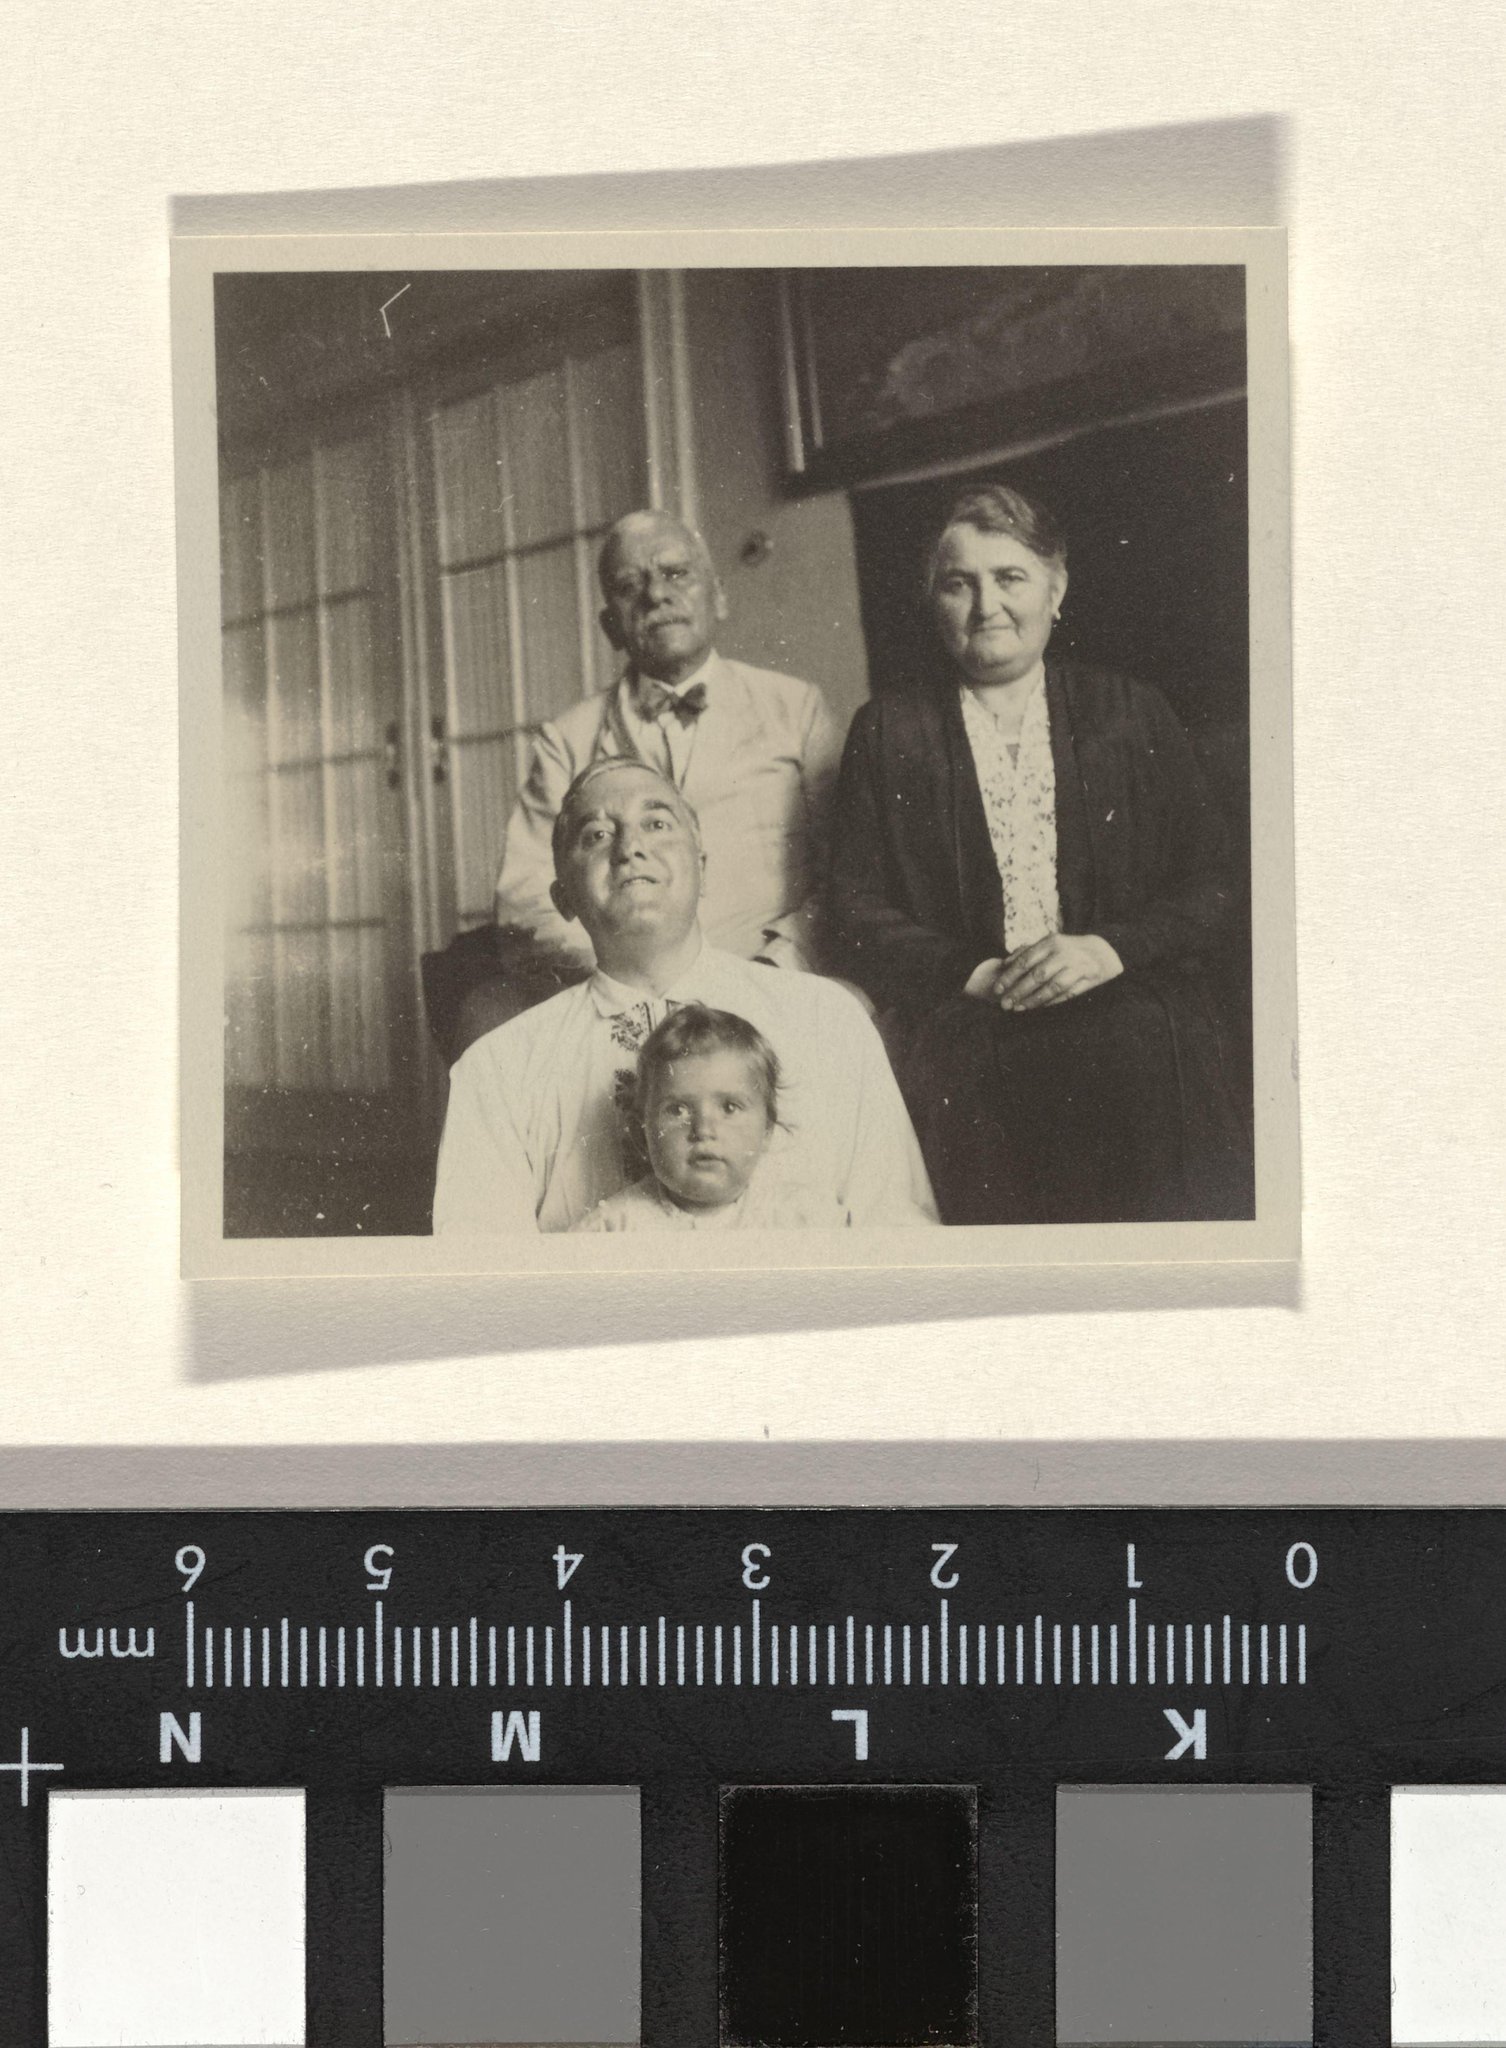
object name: photograph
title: Meir Wachenheimer, Mathilde Wachenheimer-Wertheimer, Eugen Wachenheimer, Isabel Wachenheimer in kamer, 1 september 1929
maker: Anonymous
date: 1929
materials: photographic support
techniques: gelatin silver print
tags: eugen wachenheimer, isabel wachenheimer-elon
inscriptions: number: ‘67’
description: Dit object is onderdeel van de nalatenschap van Isabel Elon-Wachenheimer (1928-2010). Tot haar overlijden behoorde het samen met de andere objecten uit de nalatenschap tot haar privédomein van Isabel Wachenheimer. In die particuliere context zijn deze objecten tezamen en individueel aandenkens - aan de jeugd, ouders en familie van Isabel Wachenheimer vóór en tijdens de Shoah en aan haar leven na de Tweede Wereldoorlog. Isabel Wachenheimer, die van juni 1943 tot mei 1945 gevangen zat in Kamp Westerbork, Theresienstadt, Auschwitz, Lenzing a/d Oberdonau (een buitenkamp van Mauthausen), overleefde de Shoah. Haar ouders – Eugène Wachenheimer en Else Wachenheimer-Moos - werden op 14 oktober 1944 in Auschwitz-Birkenau vermoord.